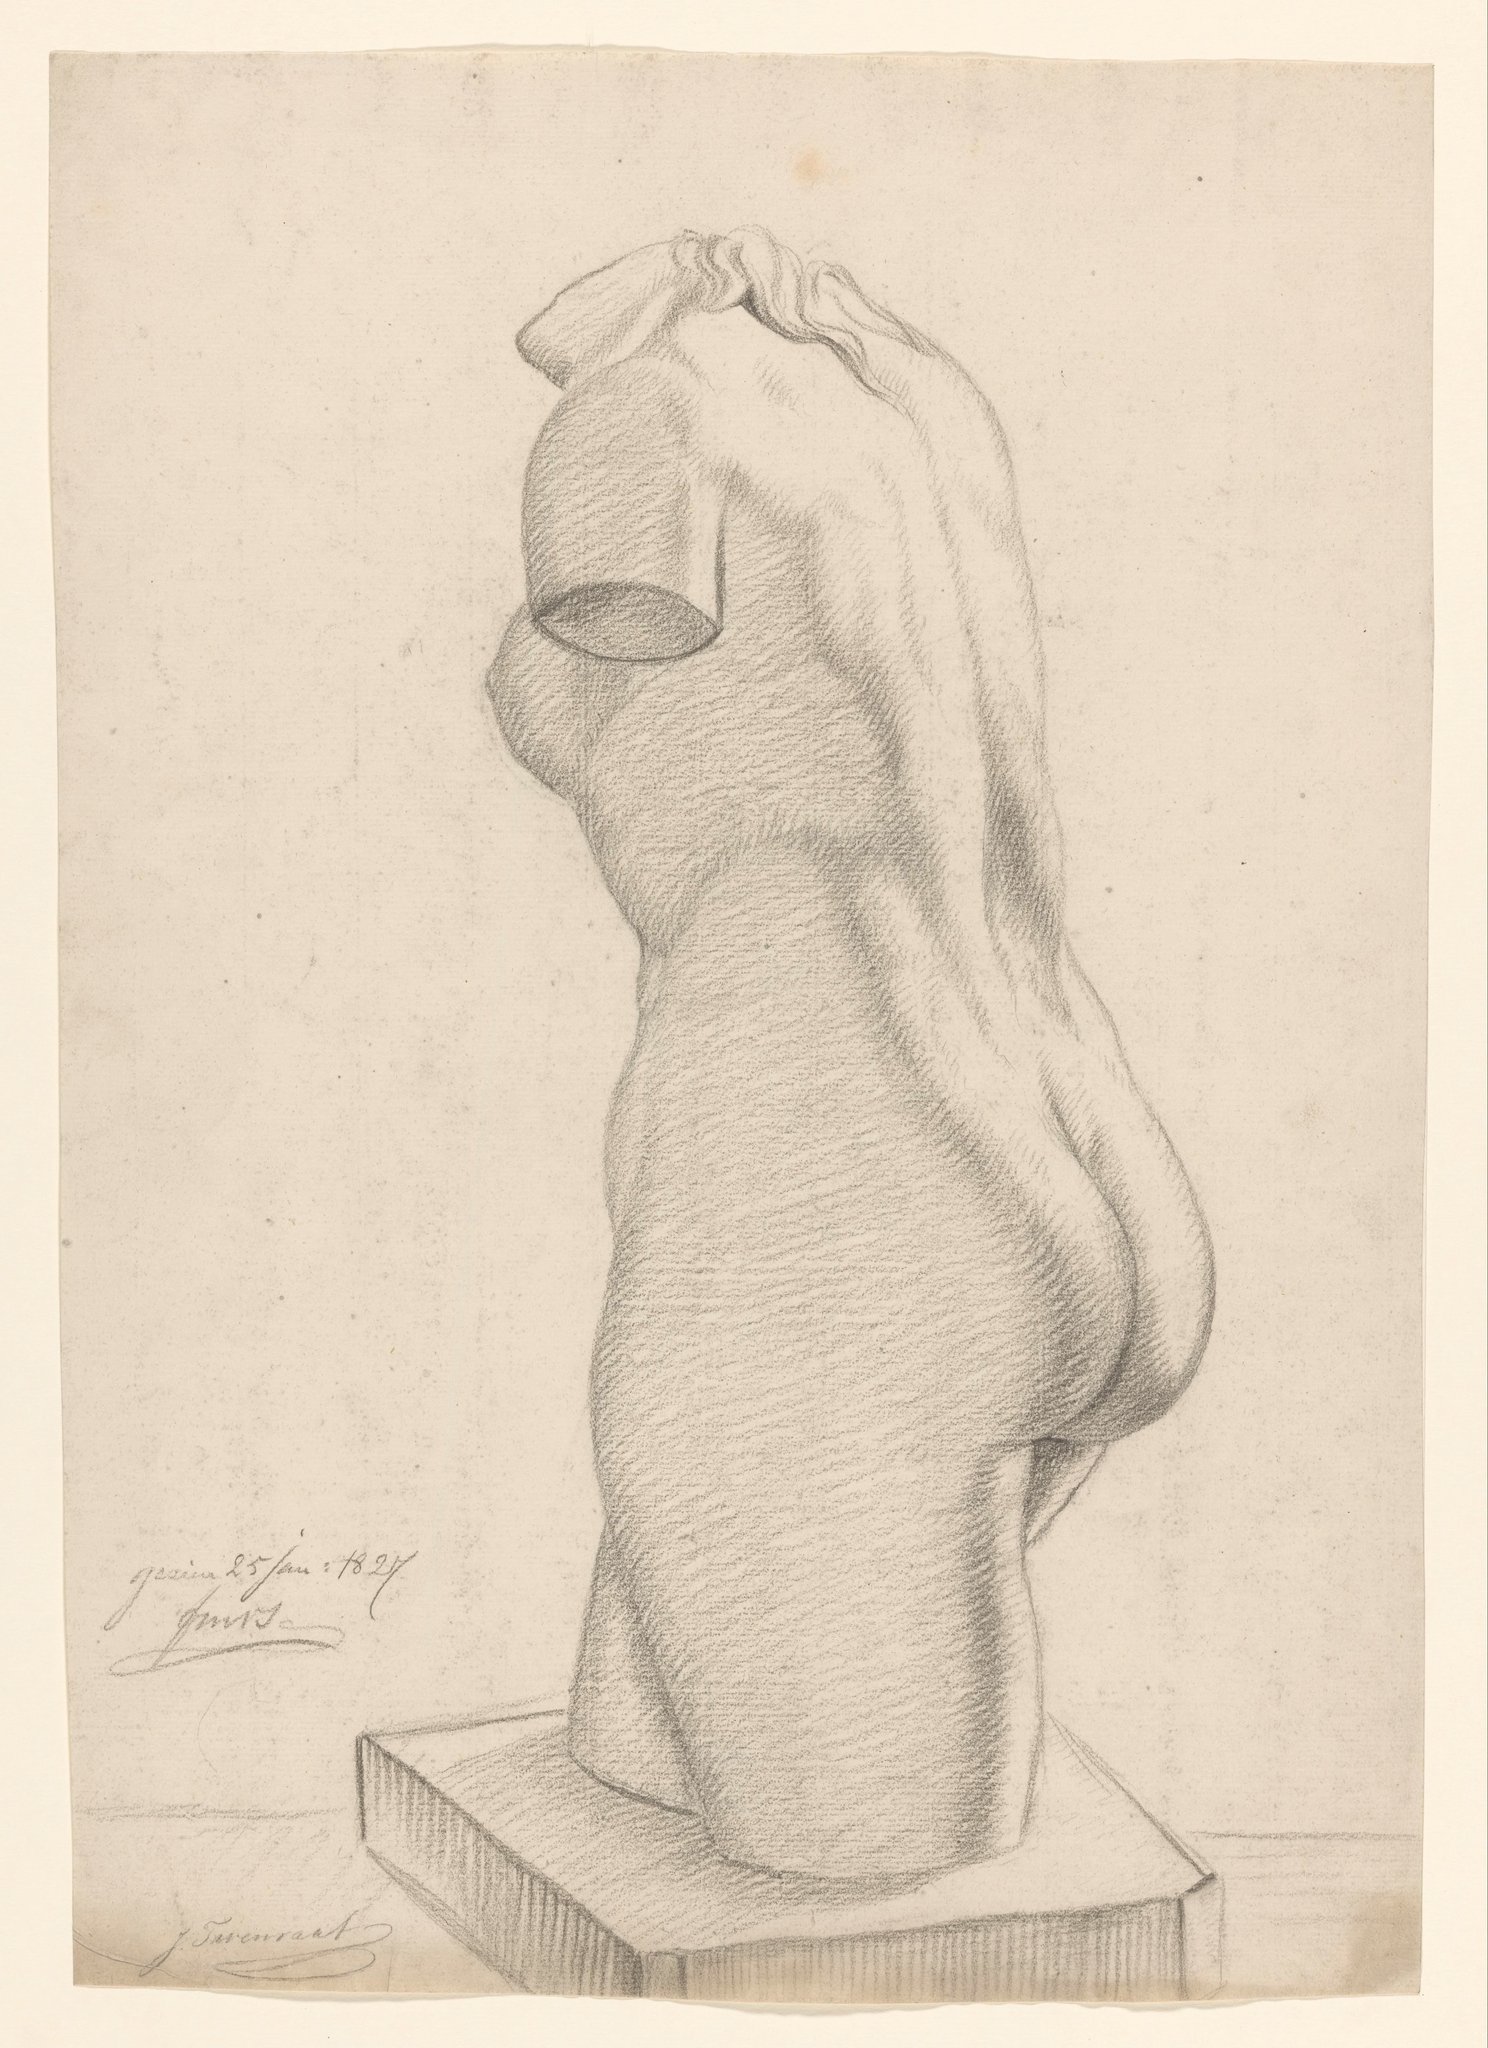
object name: drawing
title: Gips naar antiek beeld van vrouwelijk torso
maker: johannes tavenraat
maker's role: draughtsman, painter, print maker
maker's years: 1809-1881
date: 1827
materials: chalk, paper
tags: piece of sculpture, reproduction of a piece of sculpture (+ ceramics ~ arts)